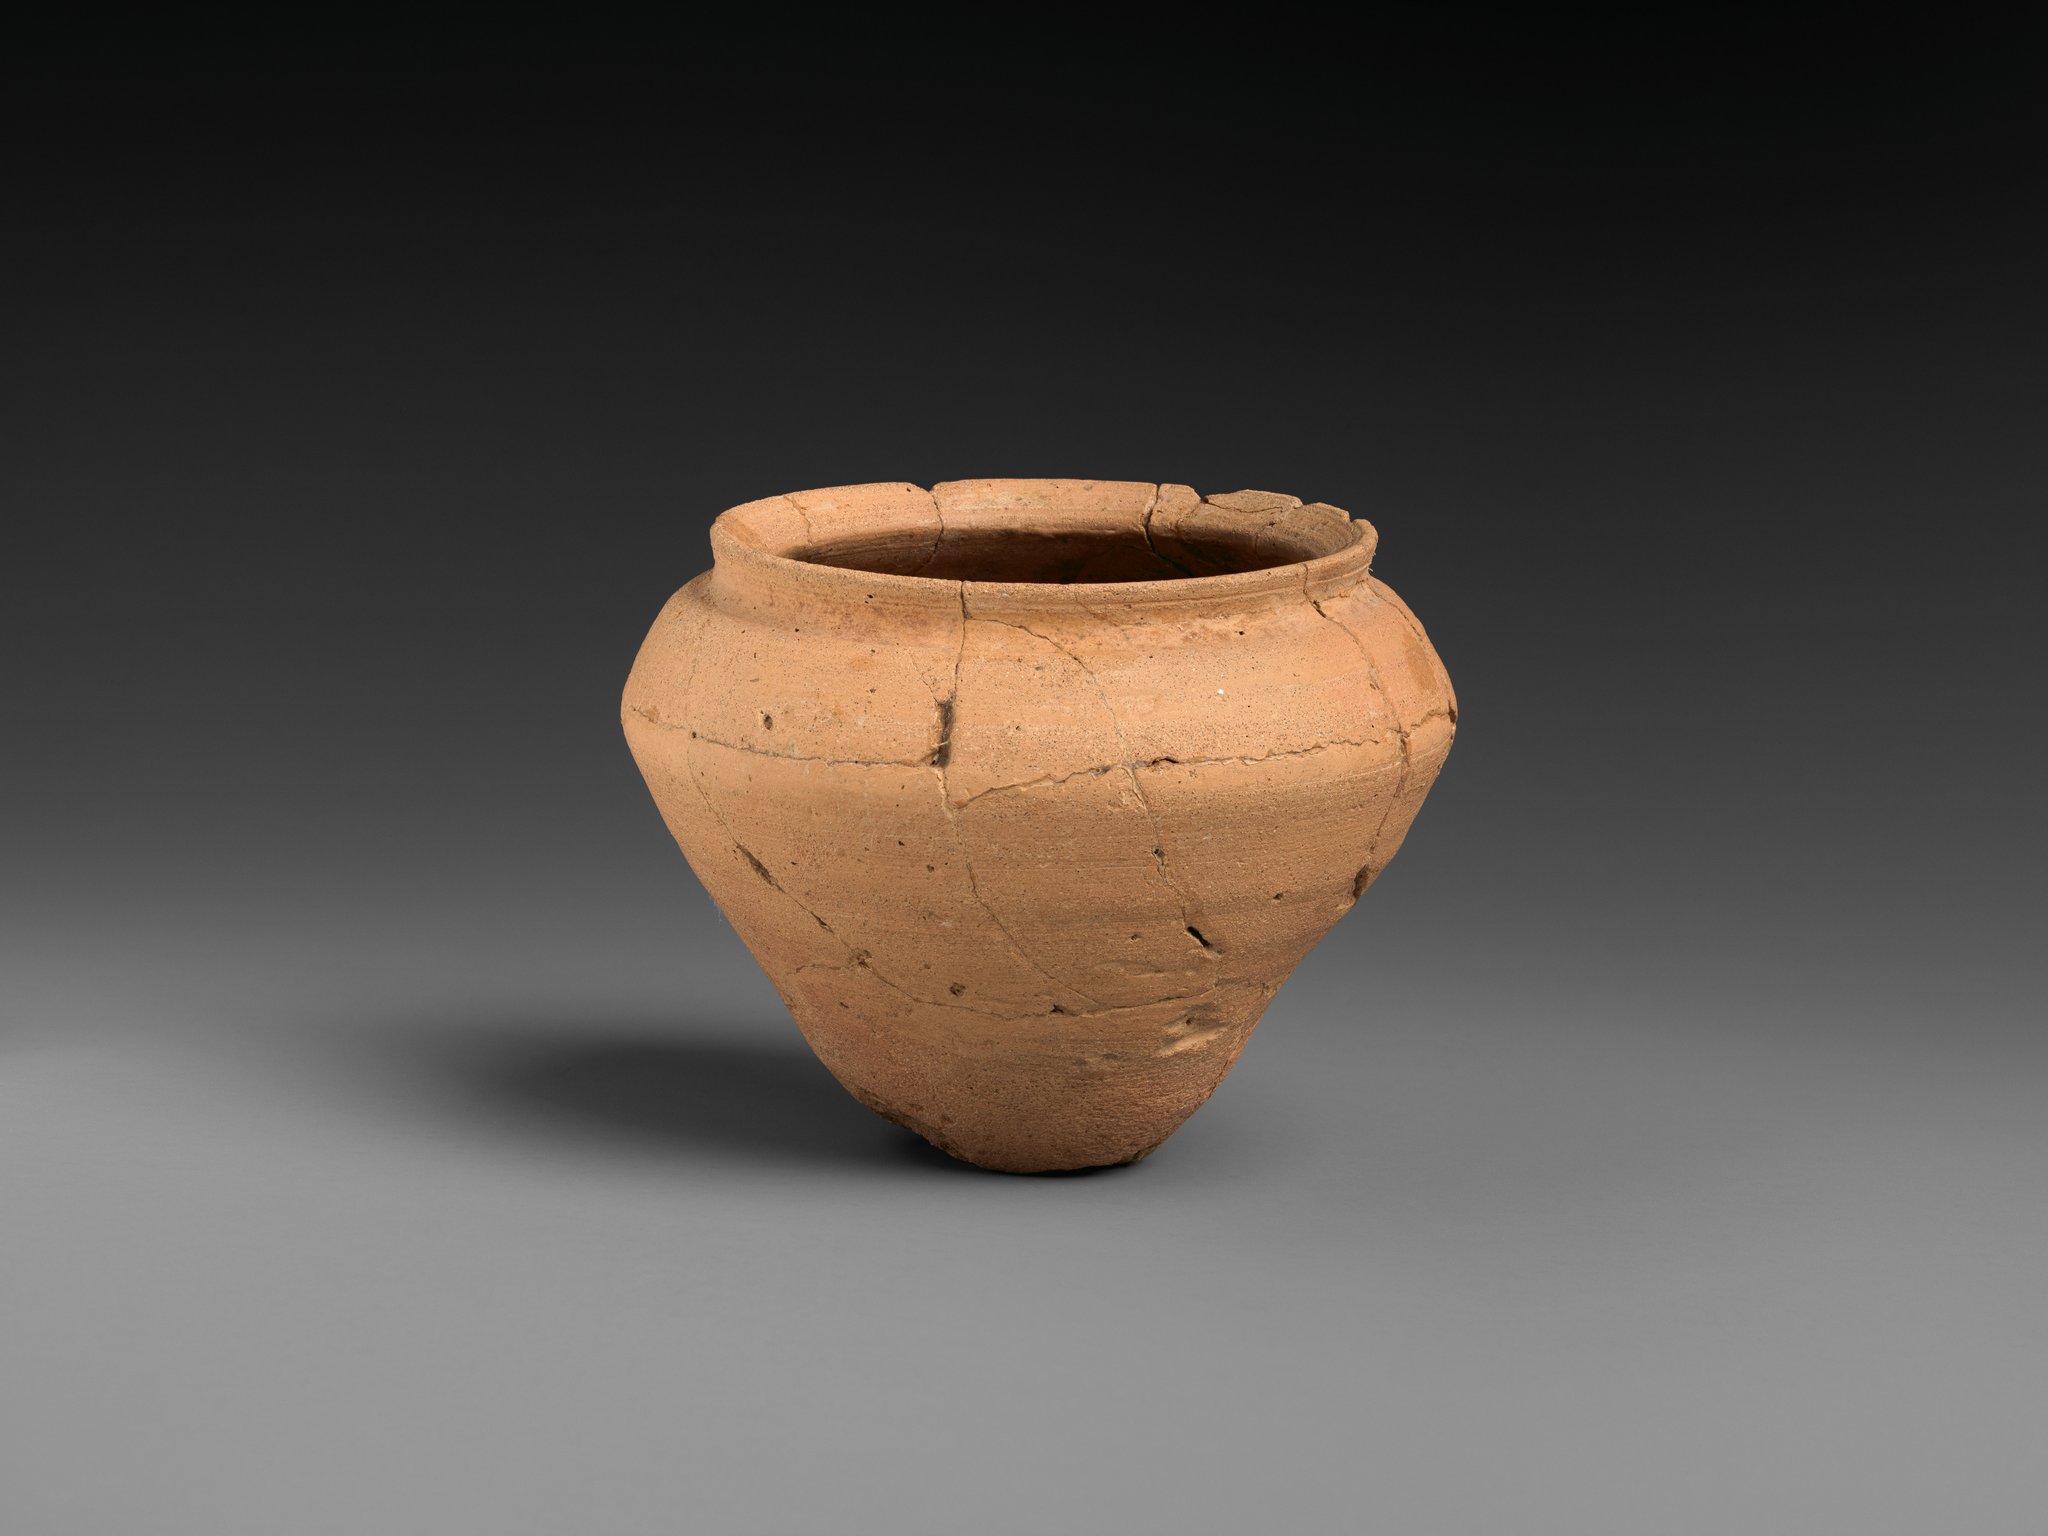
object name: bowl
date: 4000-3001 BCE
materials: ceramic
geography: mesopotamia